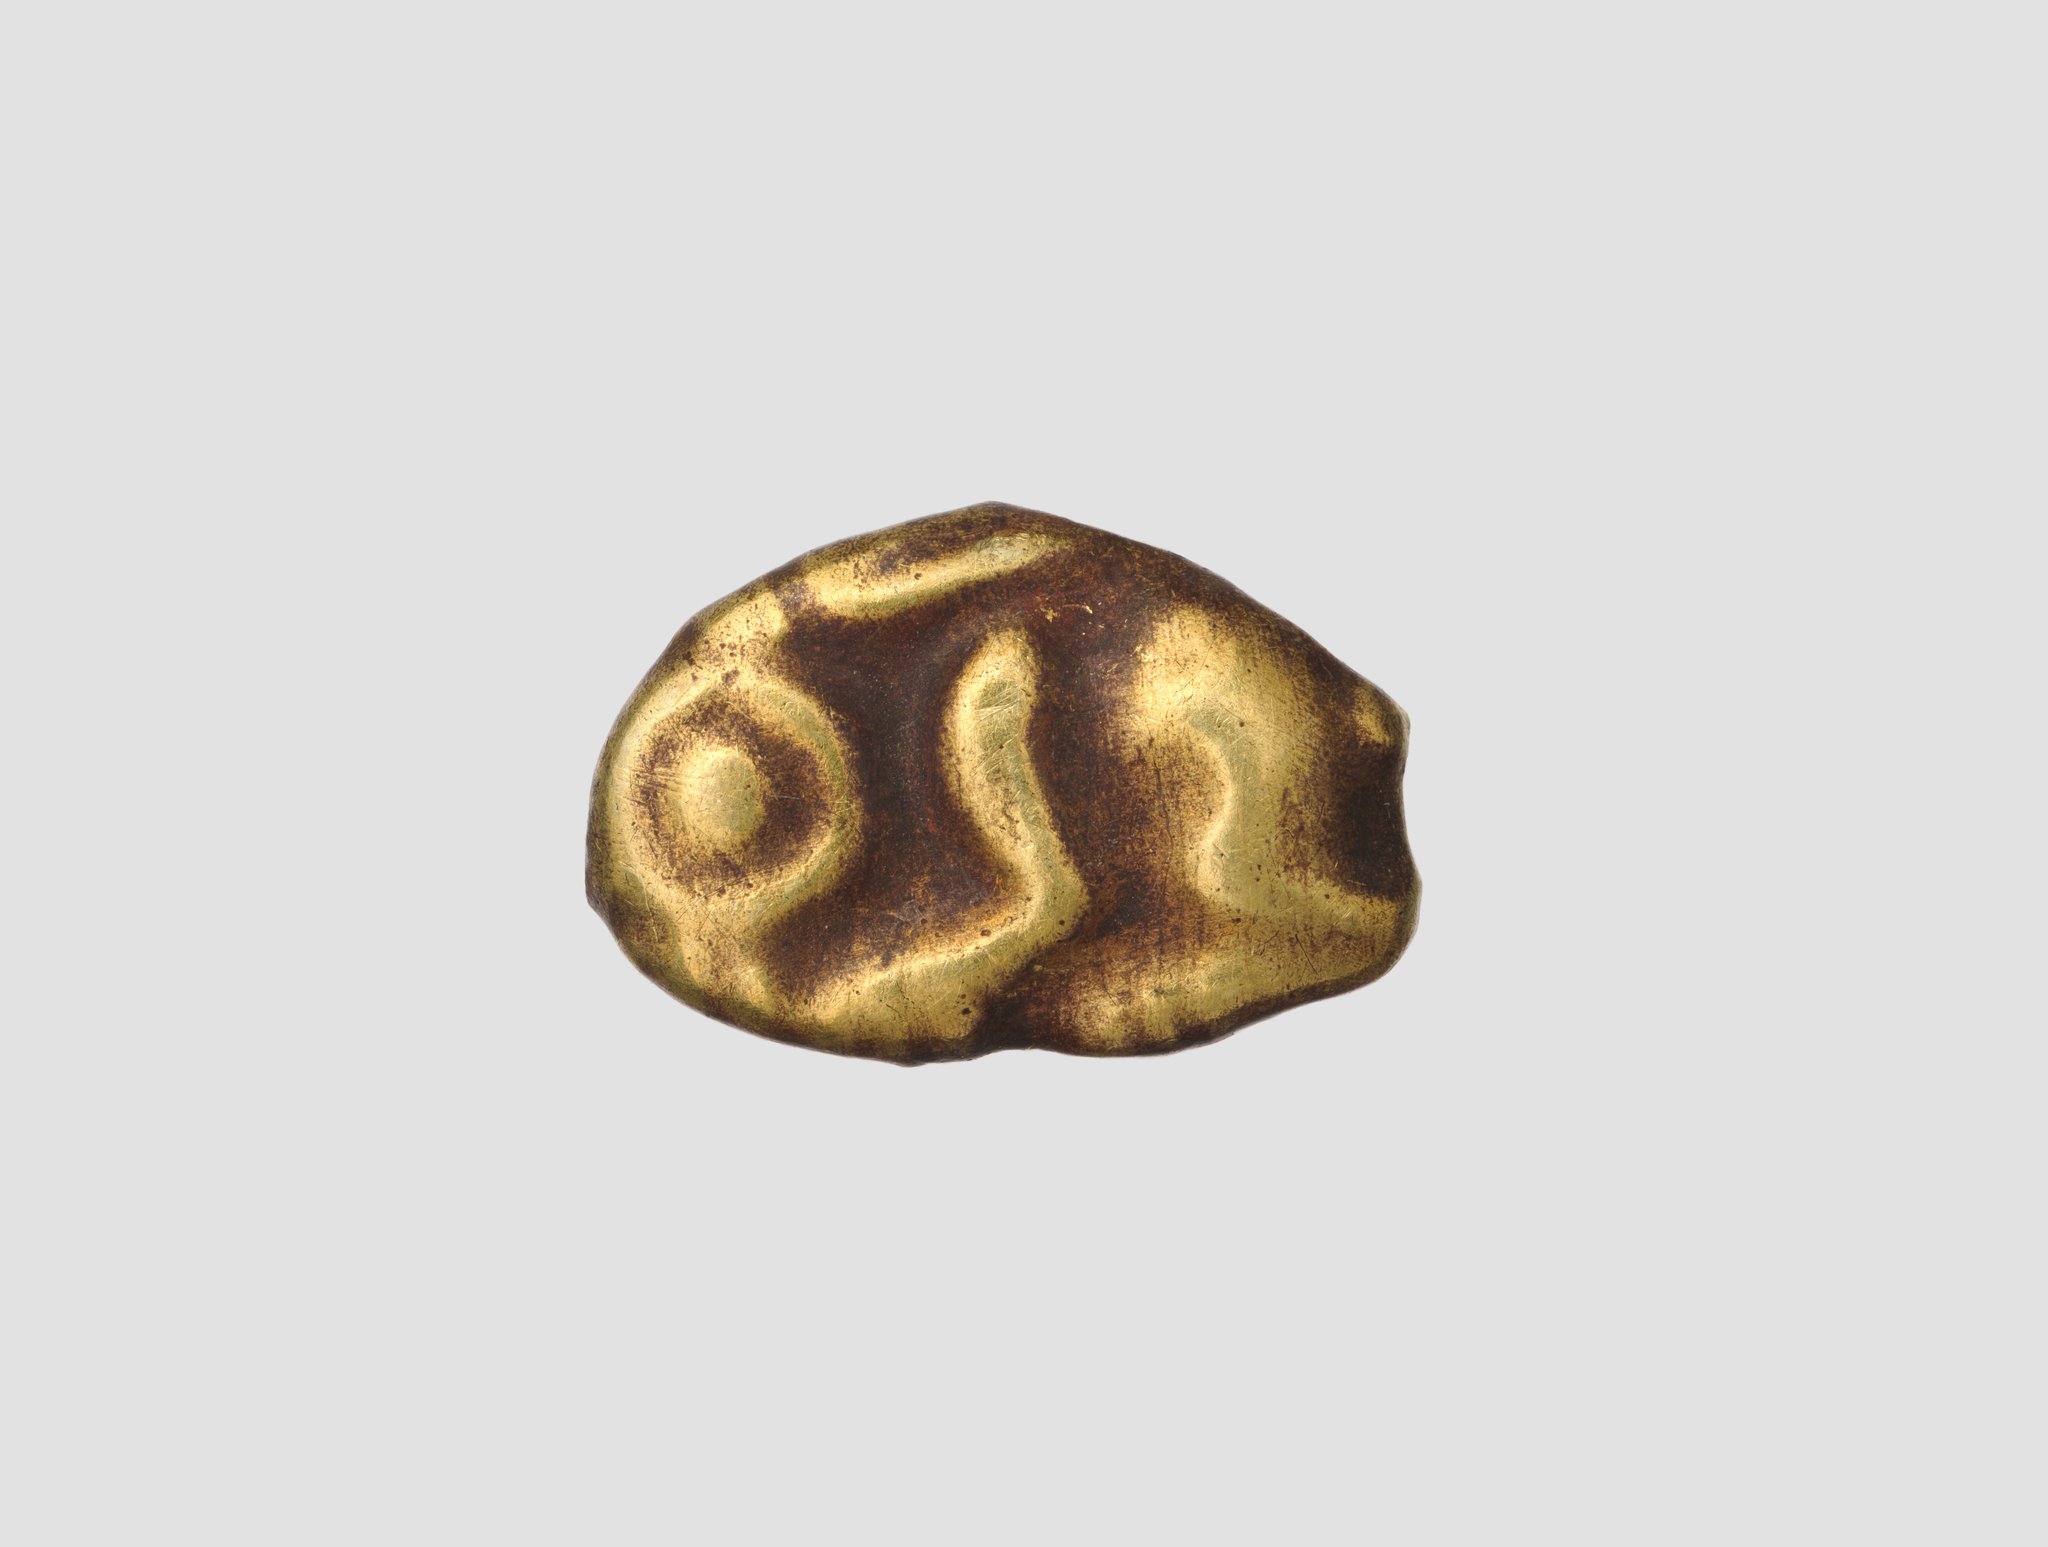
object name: appliqué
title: Appliqué with recumbent hares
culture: scythian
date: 700-501 BCE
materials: gold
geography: eurasian steppes, dniepr region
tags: rabbits